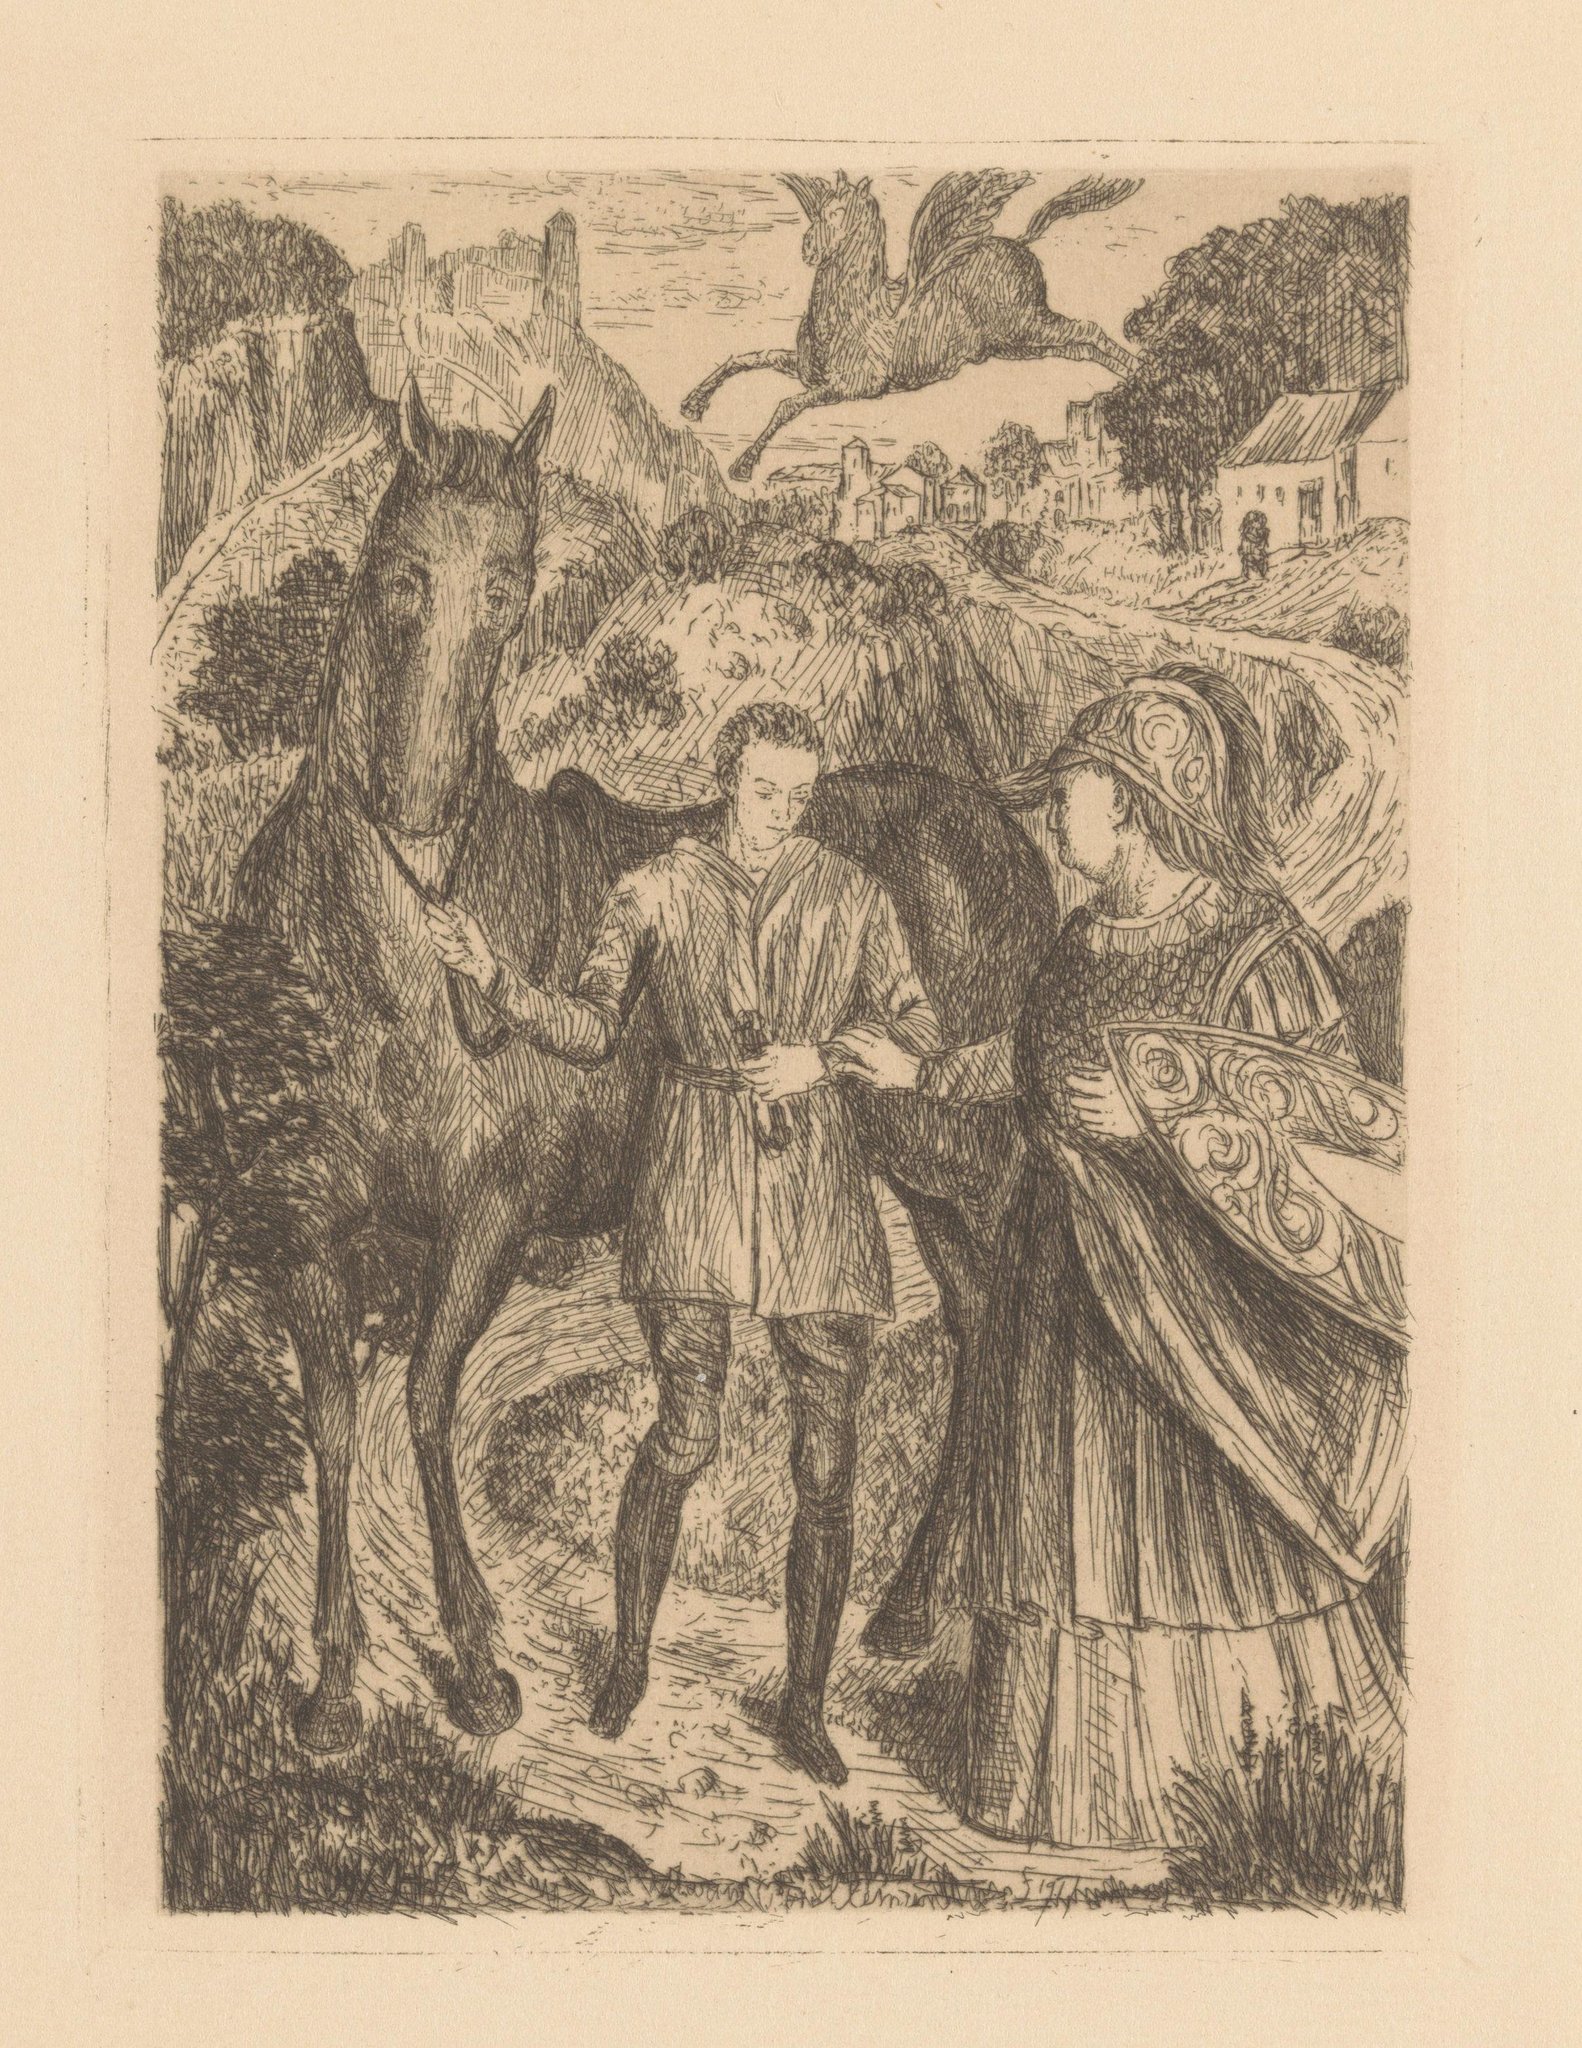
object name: print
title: Minerva spreekt Bellerophon moed in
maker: marius holleman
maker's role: draughtsman, print maker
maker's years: 1878-1926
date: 1917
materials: paper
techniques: etching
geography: groningen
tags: pegasus, the winged horse, (story of) minerva (pallas, athena), (story of) bellerophon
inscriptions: collector's mark: Lugt 2228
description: Minerva legt haar hand op Bellerophons arm. Op de achtergrond vliegt Pegasus.